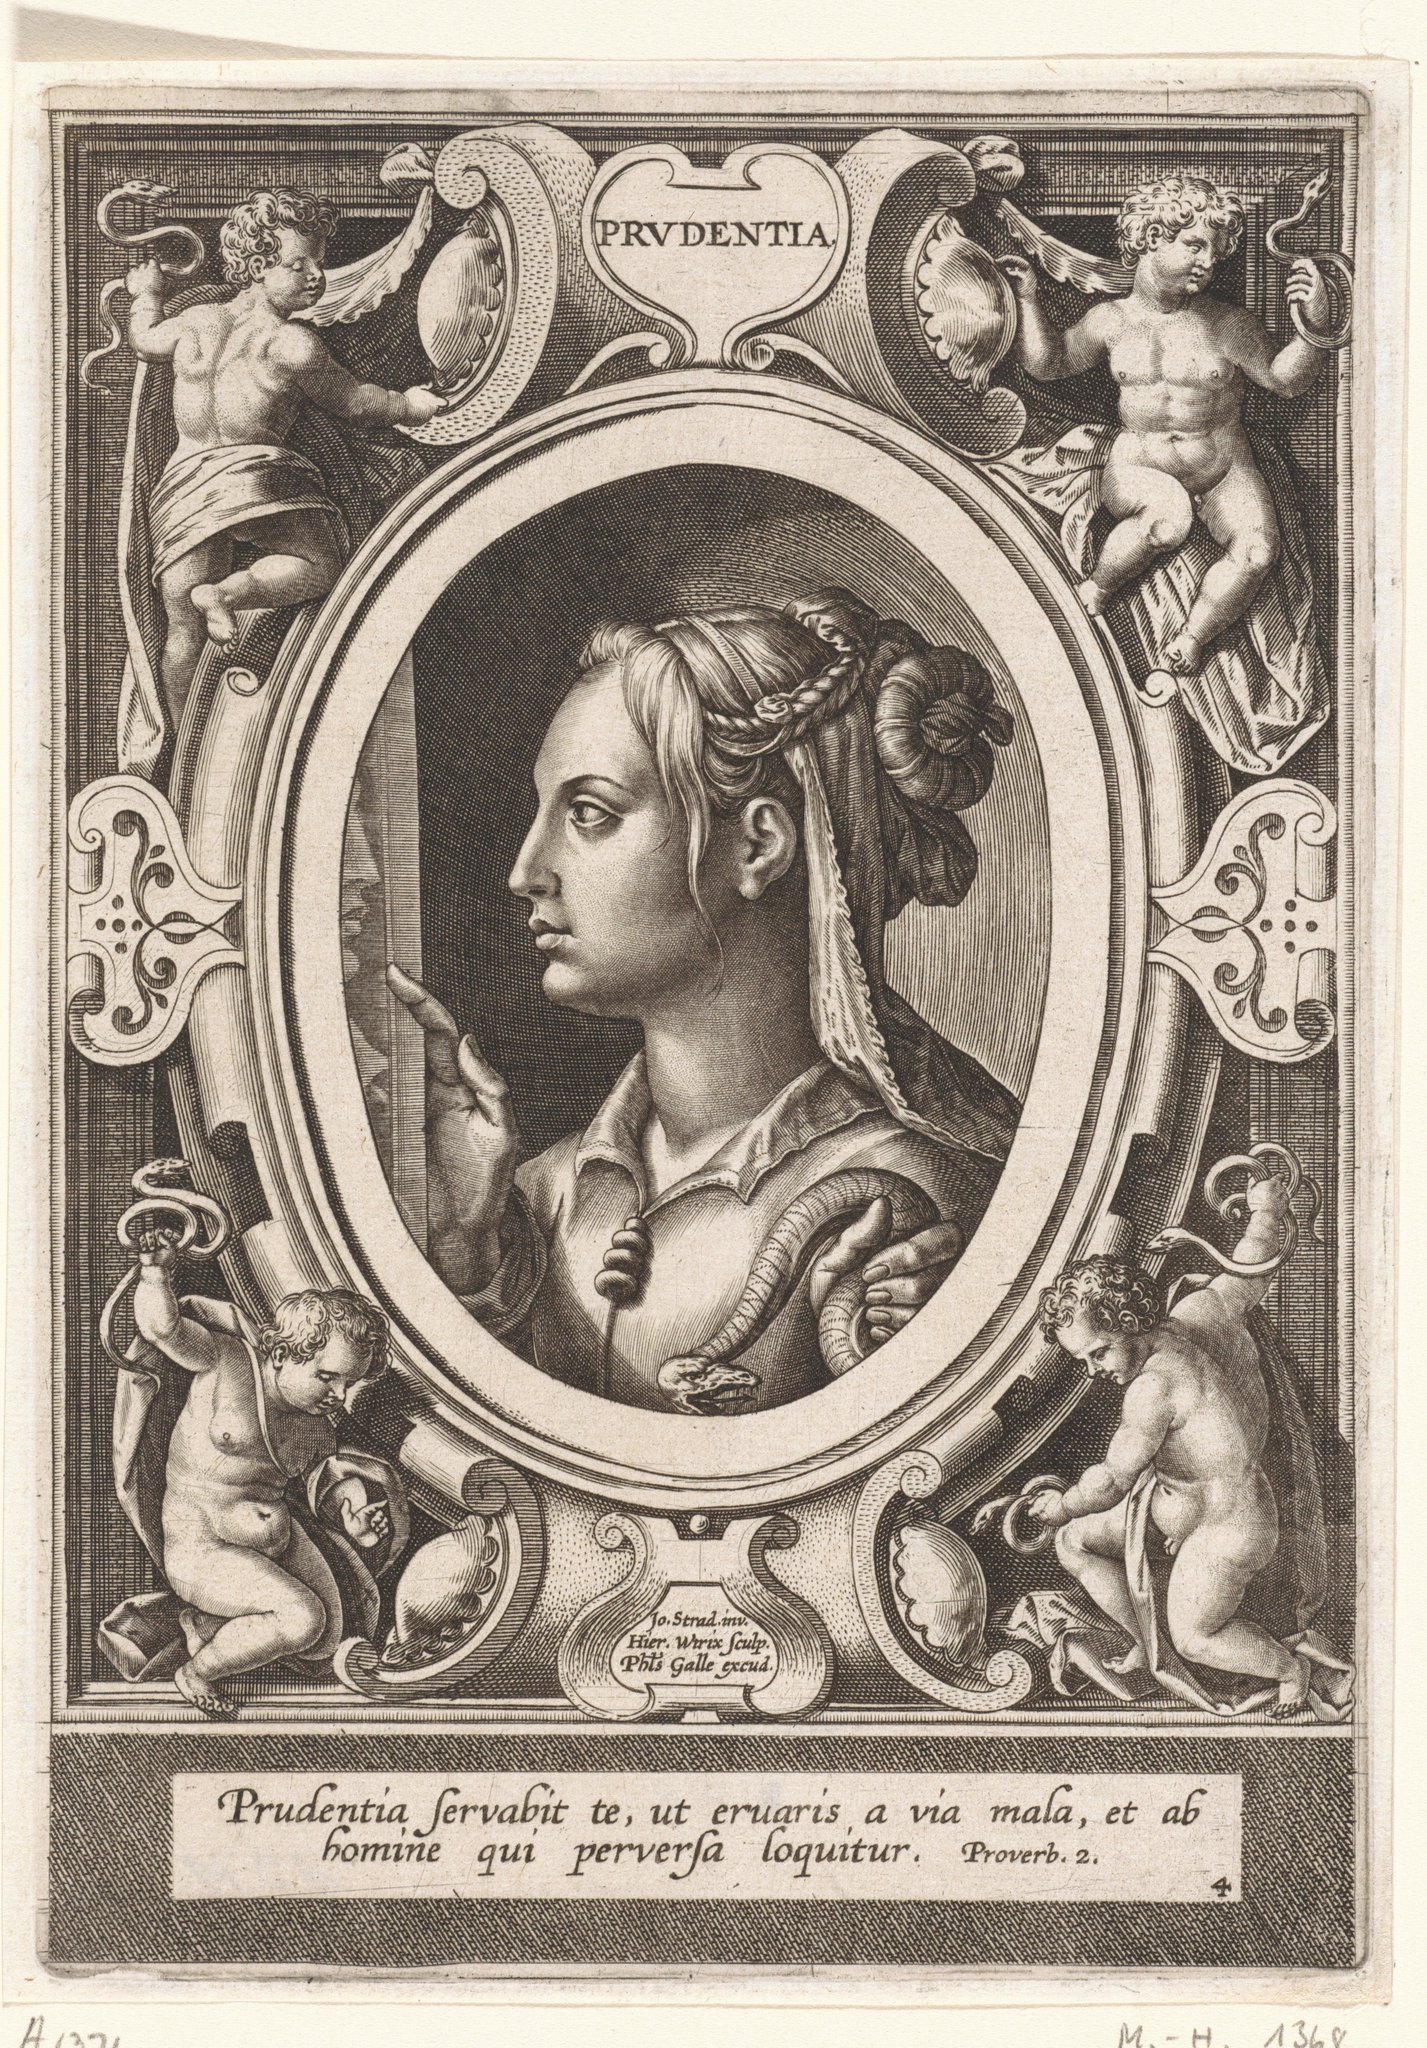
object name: print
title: Voorzichtigheid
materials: paper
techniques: engraving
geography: antwerp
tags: prudence, 'prudentia'; 'prudenza' (ripa) ~ one of the four cardinal virtues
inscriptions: collector's mark: Lugt 2542, collector's mark: Lugt 2233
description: Buste van de vrouwelijke personificatie van Voorzichtigheid. Ze bekijkt zichzelf in een spiegel en houdt een slang in haar hand. De voorstelling is gevat in een cartouche, omringd door putti. In het kader in de marge een tweeregelig Bijbelcitaat uit Spr. 2 in het Latijn.